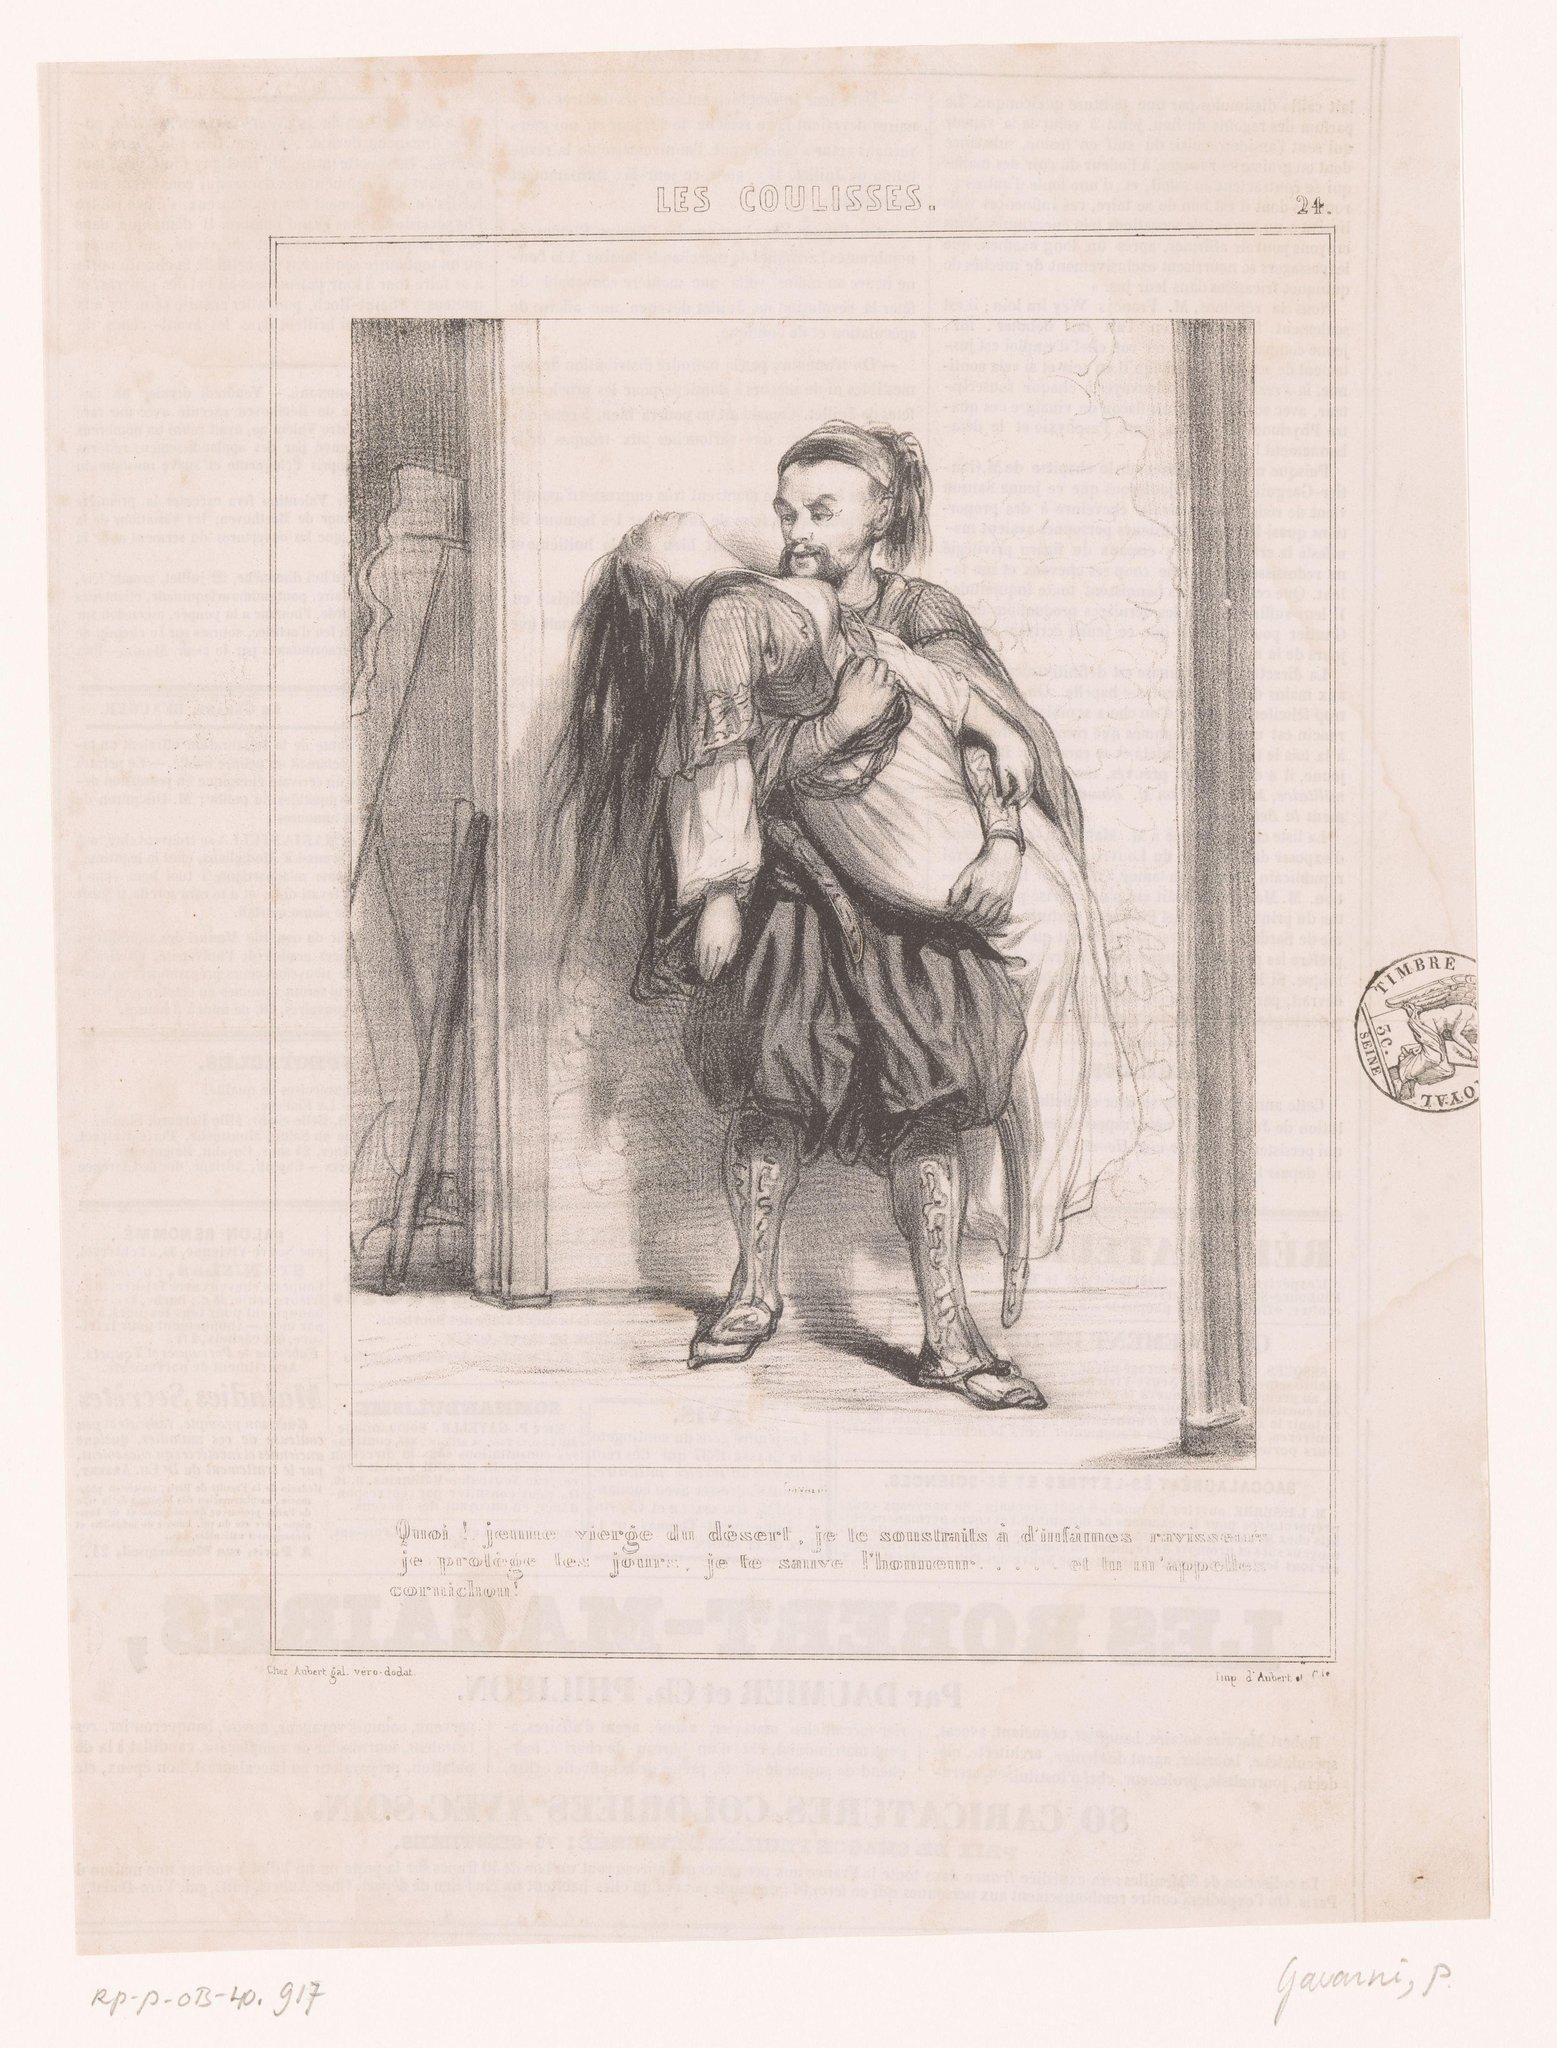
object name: print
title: Achter de schermen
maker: paul gavarni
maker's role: draughtsman, print maker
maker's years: 1804-1866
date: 1838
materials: paper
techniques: lithograph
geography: paris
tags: behind the stage, actress (on the stage), actor (on the stage)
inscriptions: stamp: ‘Timbre Royal/ 3c./ Seine’, collector's mark: Lugt 2228a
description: Vlak voordat ze op moeten komen, geeft de actrice haar collega een scheldnaam. De acteur, die in het toneelstuk haar redder is, vindt dat niet terecht.